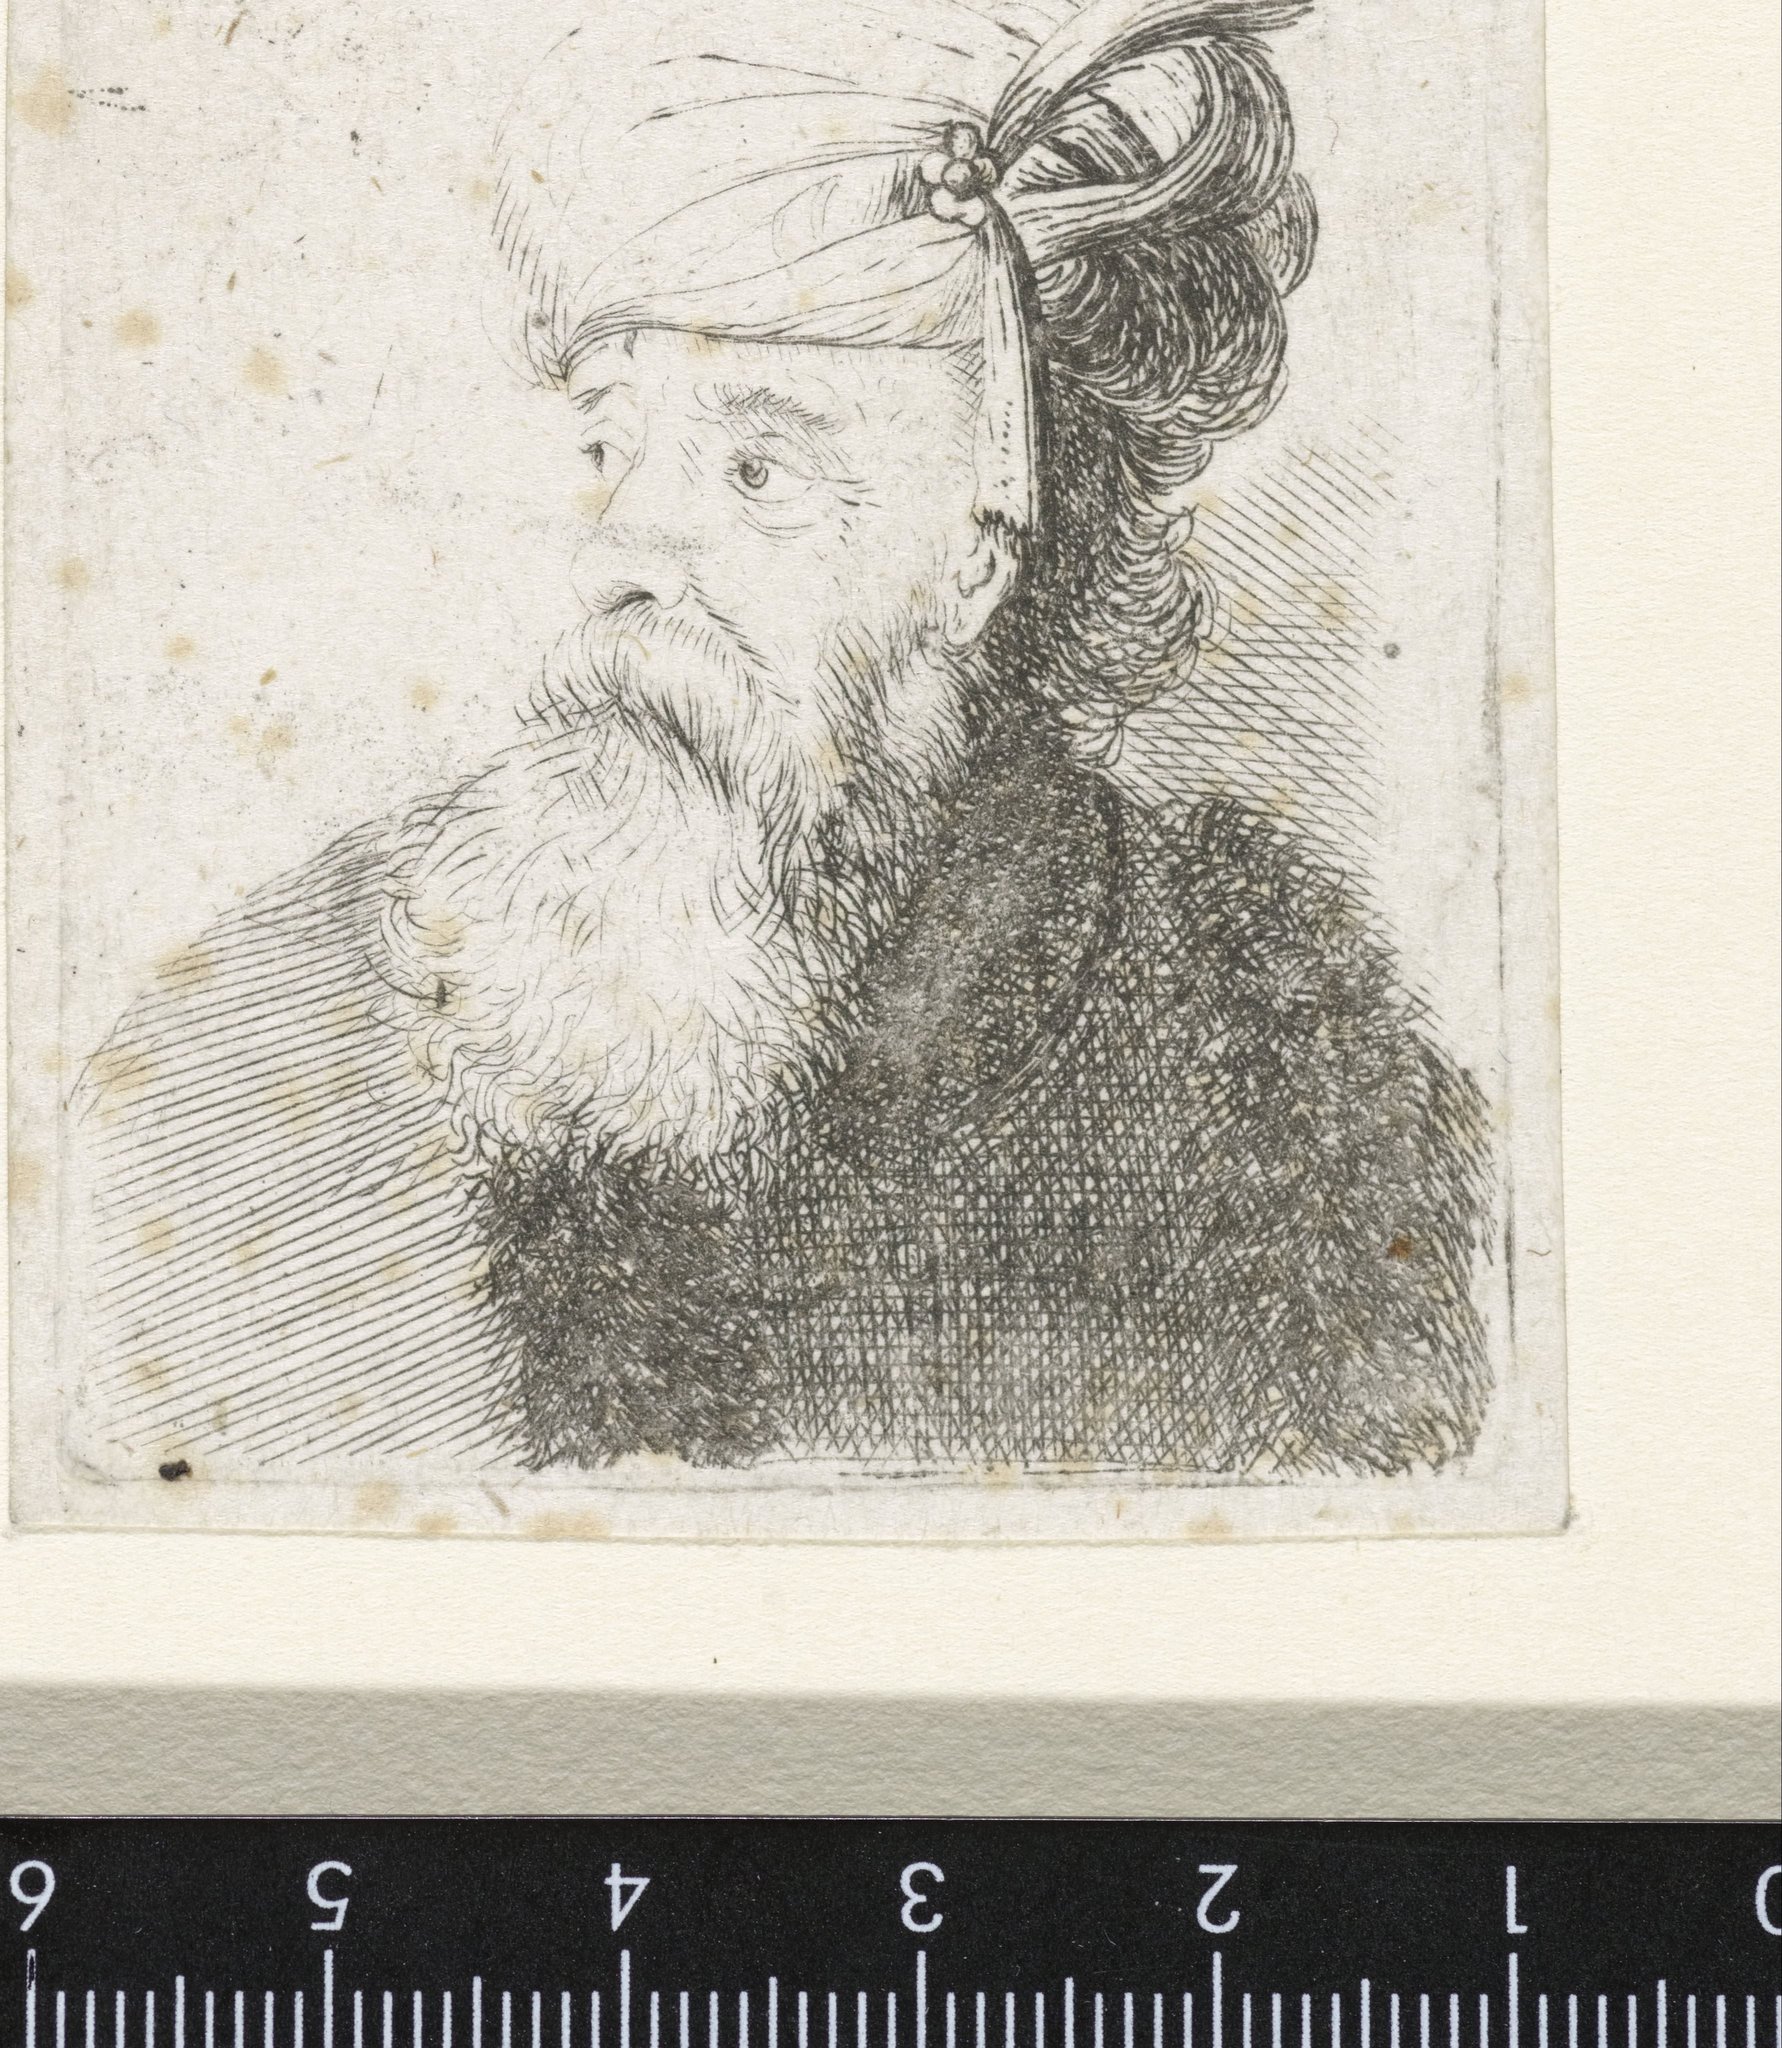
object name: print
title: Buste van een man met tulband en baard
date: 1616-1719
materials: paper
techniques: engraving, etching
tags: head-gear: turban (+ men's clothes)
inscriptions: collector's mark: Lugt 2165